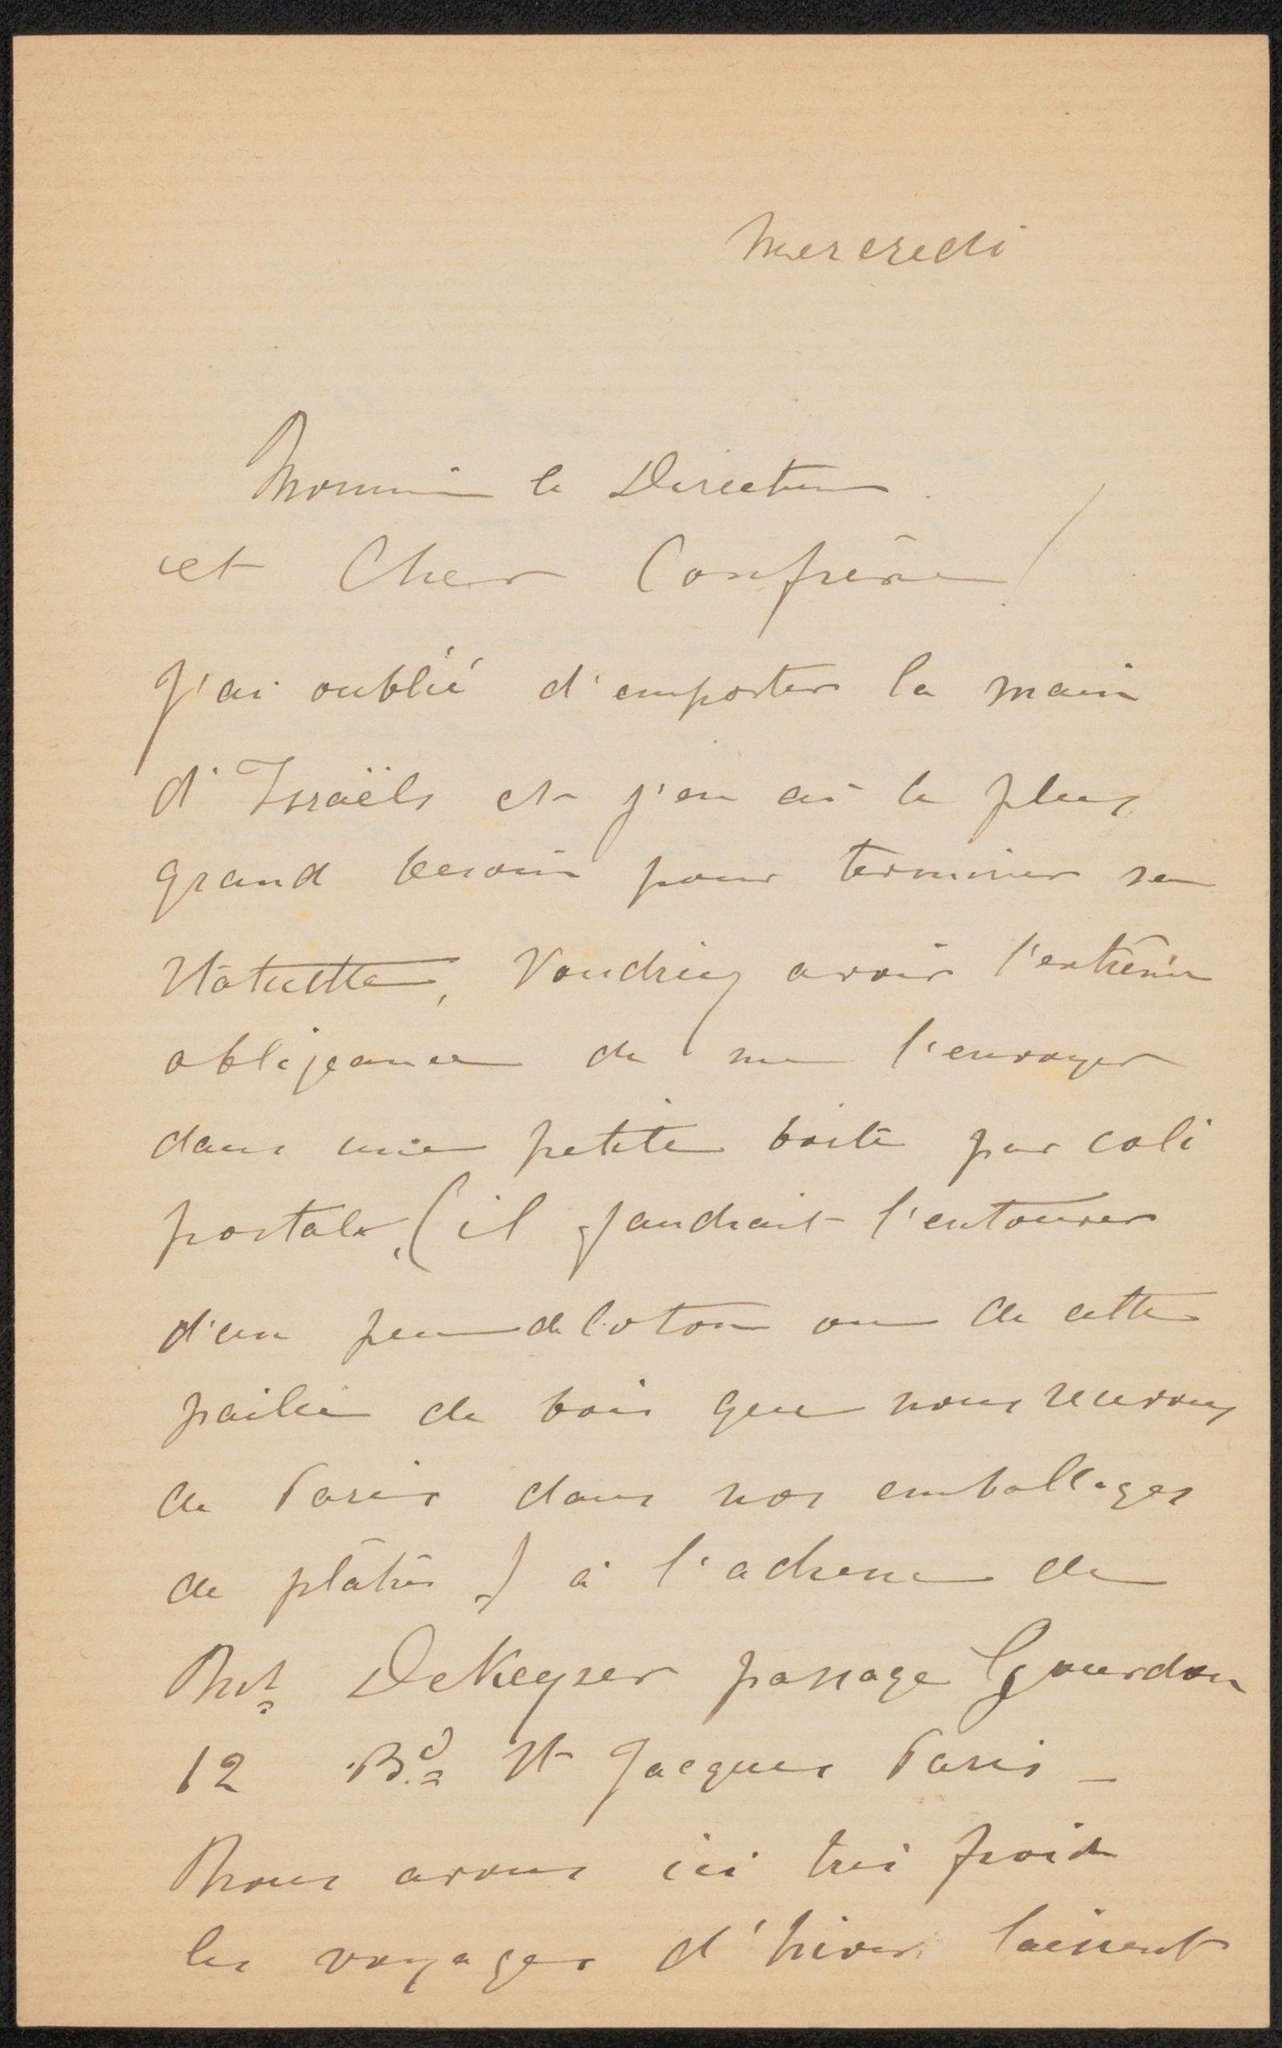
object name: letter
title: Brief aan August Allebé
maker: ferdinand leenhoff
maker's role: print maker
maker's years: 1841-1914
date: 1851-1914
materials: ink, paper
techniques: pen, writing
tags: august allebé, the hague, painter, print maker, draughtsman, jozef israëls, sculpture, paris